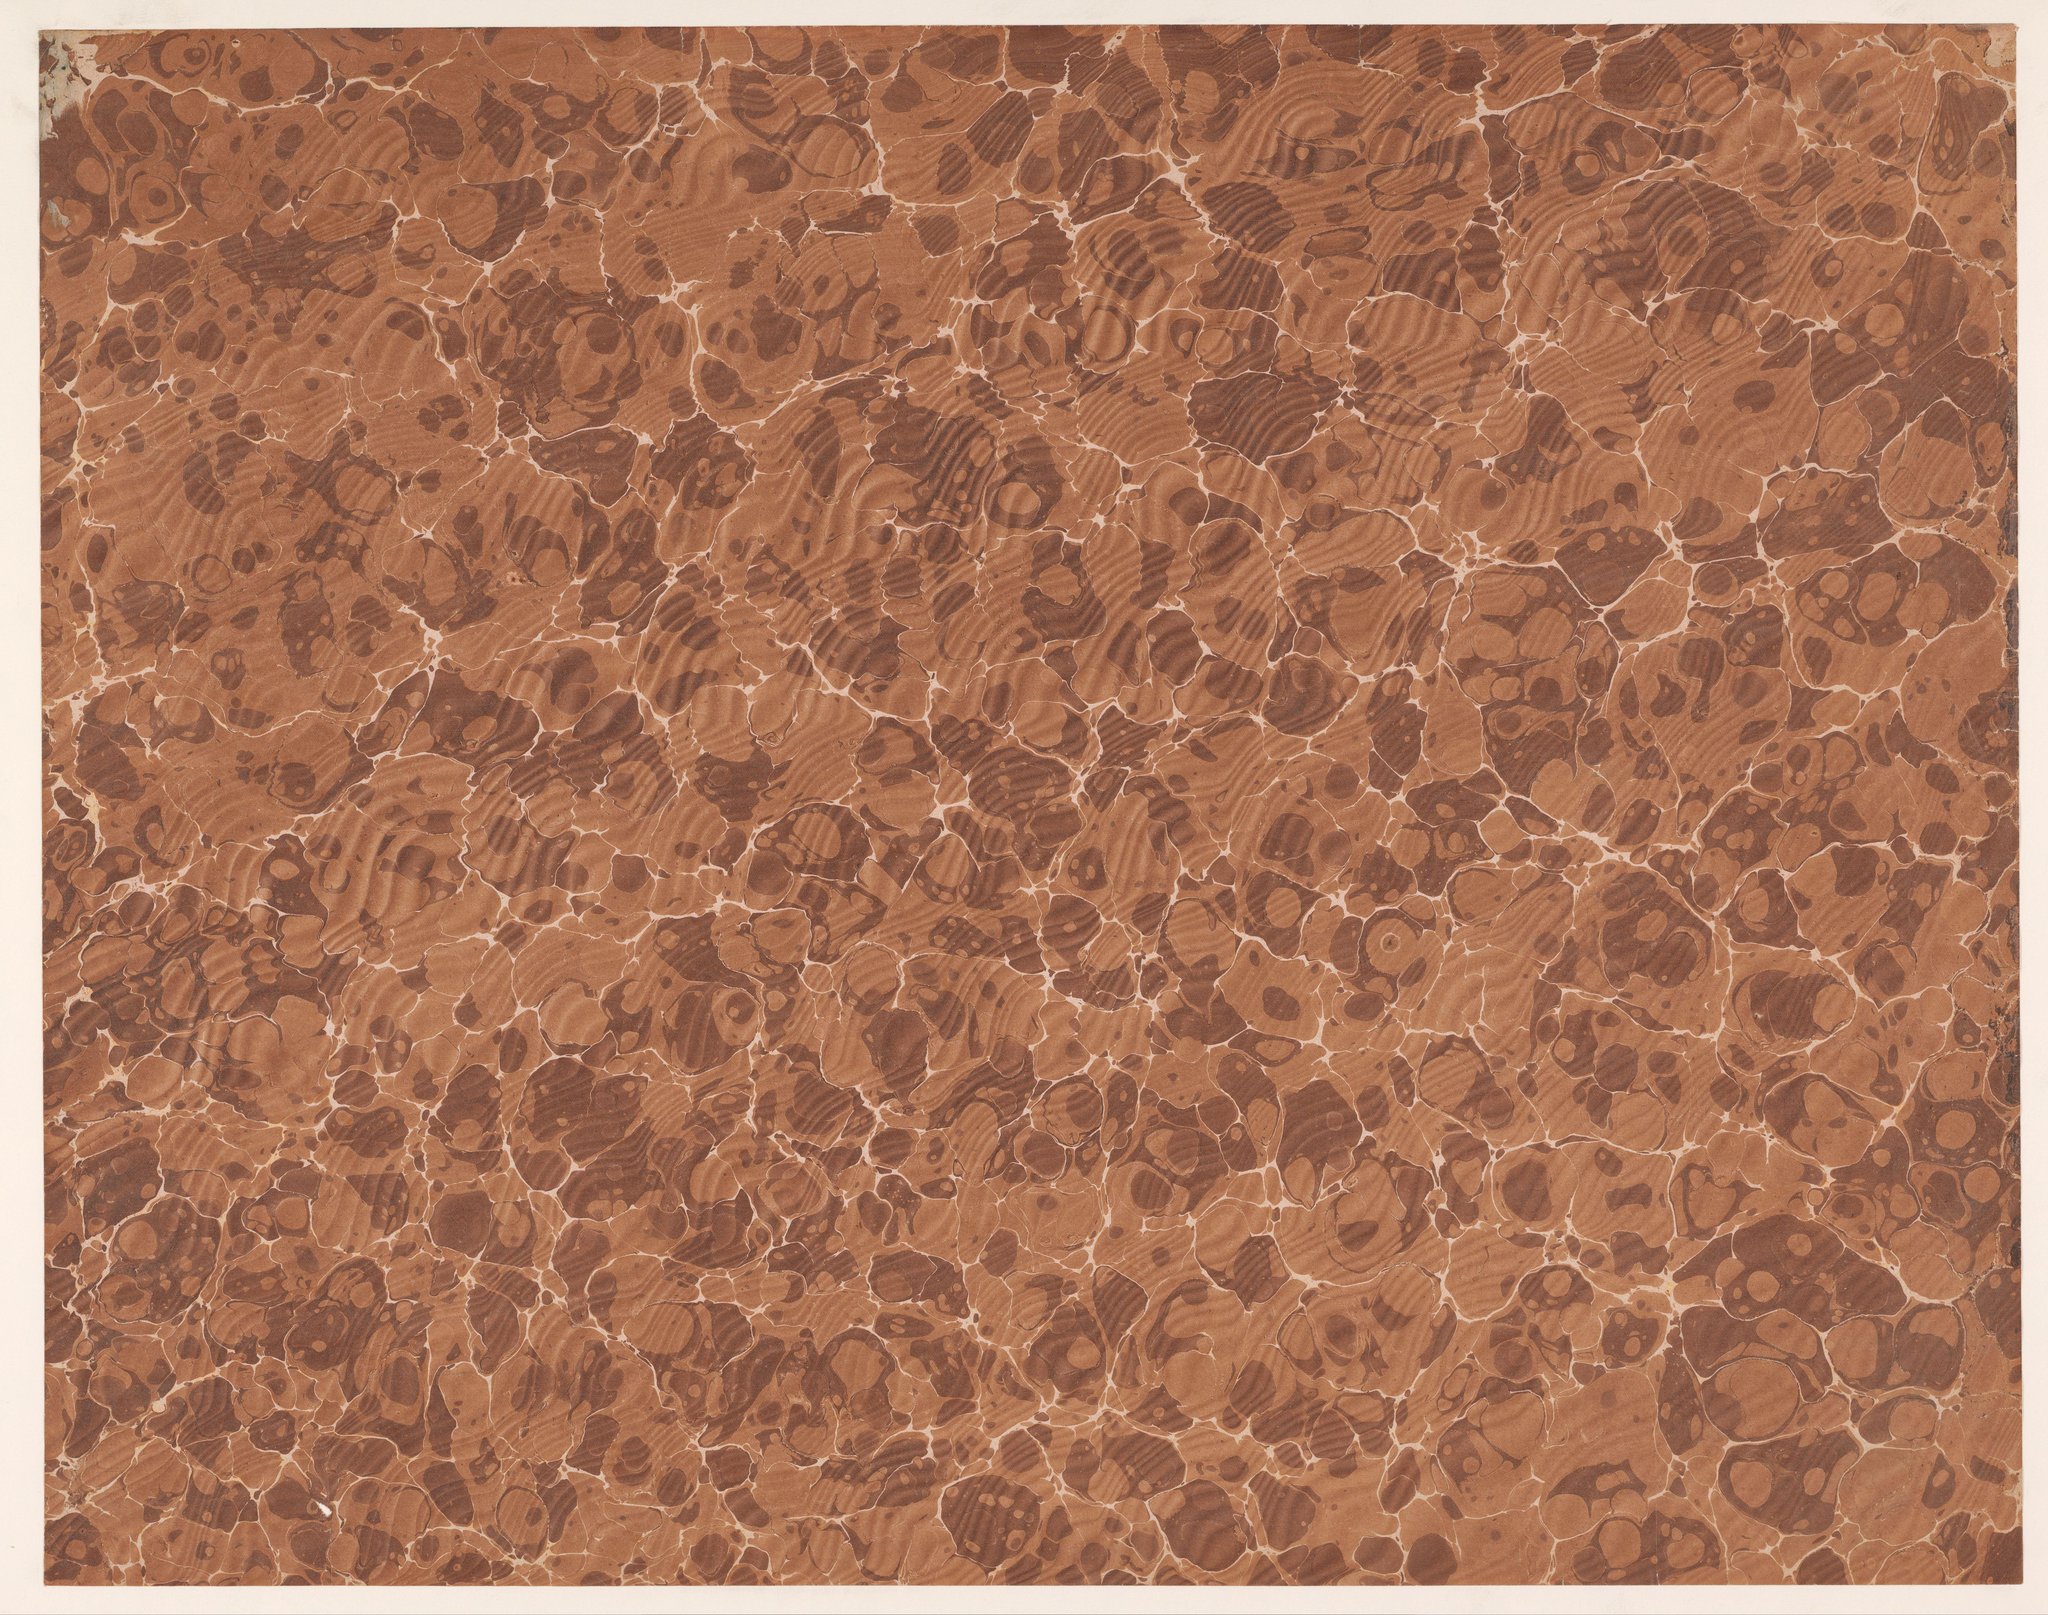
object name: marbled paper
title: Moirémarmer in bruin en lichtbruin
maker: Anonymous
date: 1900-2000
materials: lacquer, paint, paper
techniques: marbling